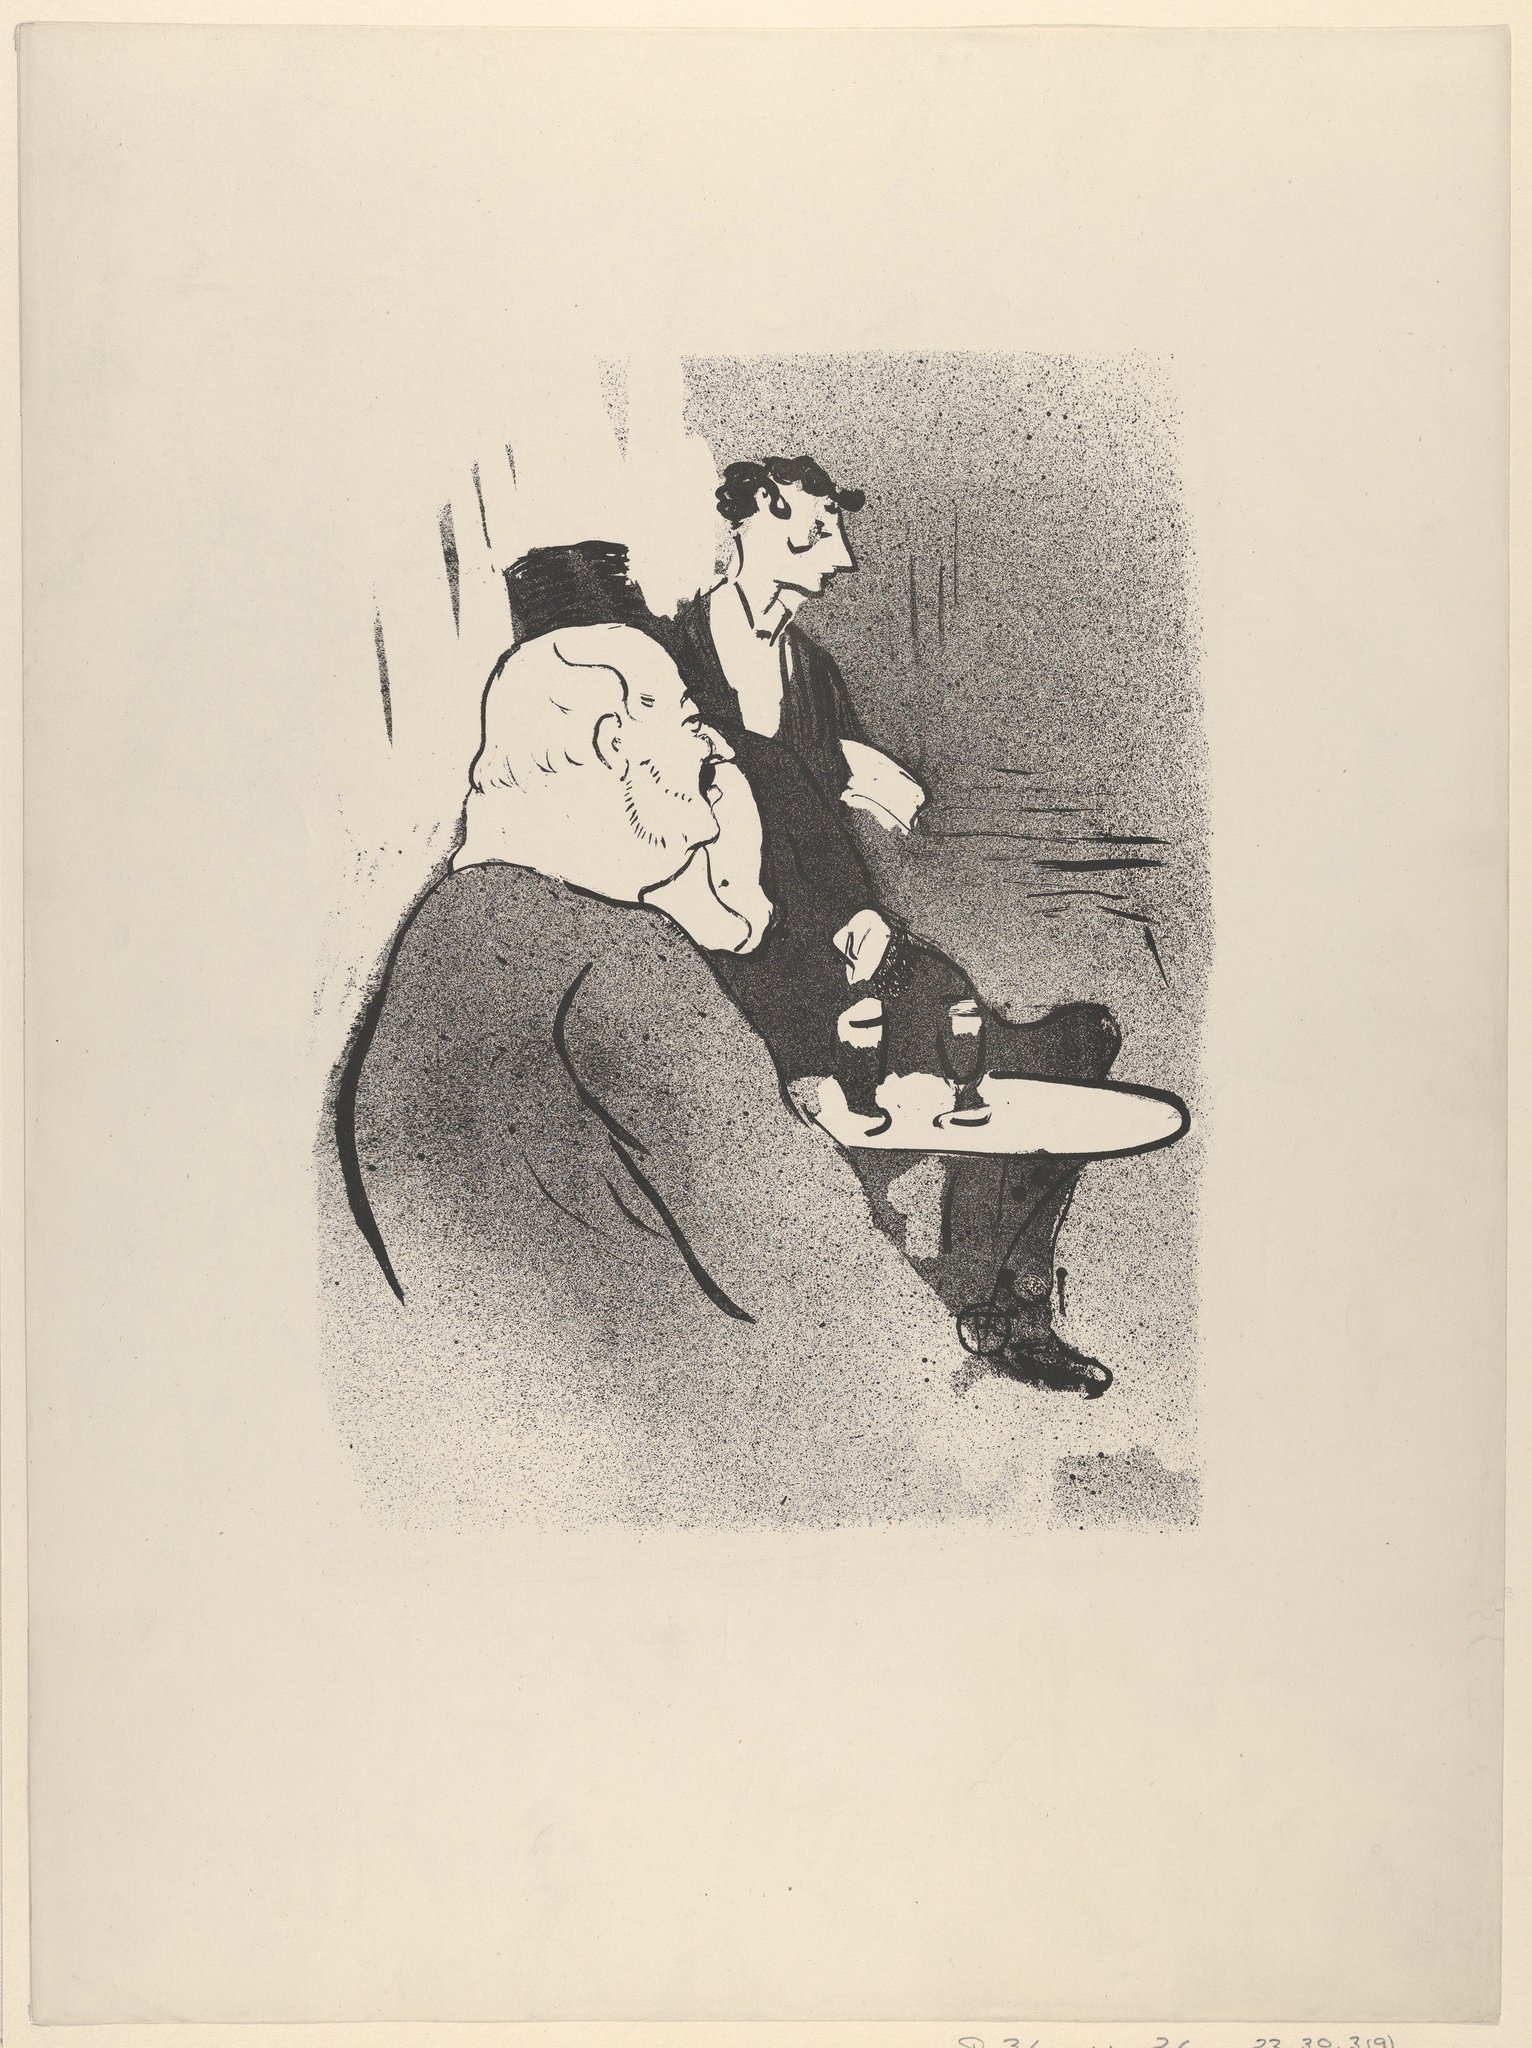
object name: print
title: Ducarre at Les Ambassadeurs (from Le Café Concert)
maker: henri de toulouse-lautrec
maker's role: artist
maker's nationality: french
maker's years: 1864-1901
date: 1893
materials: crayon, paper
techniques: lithograph, printing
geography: france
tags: men